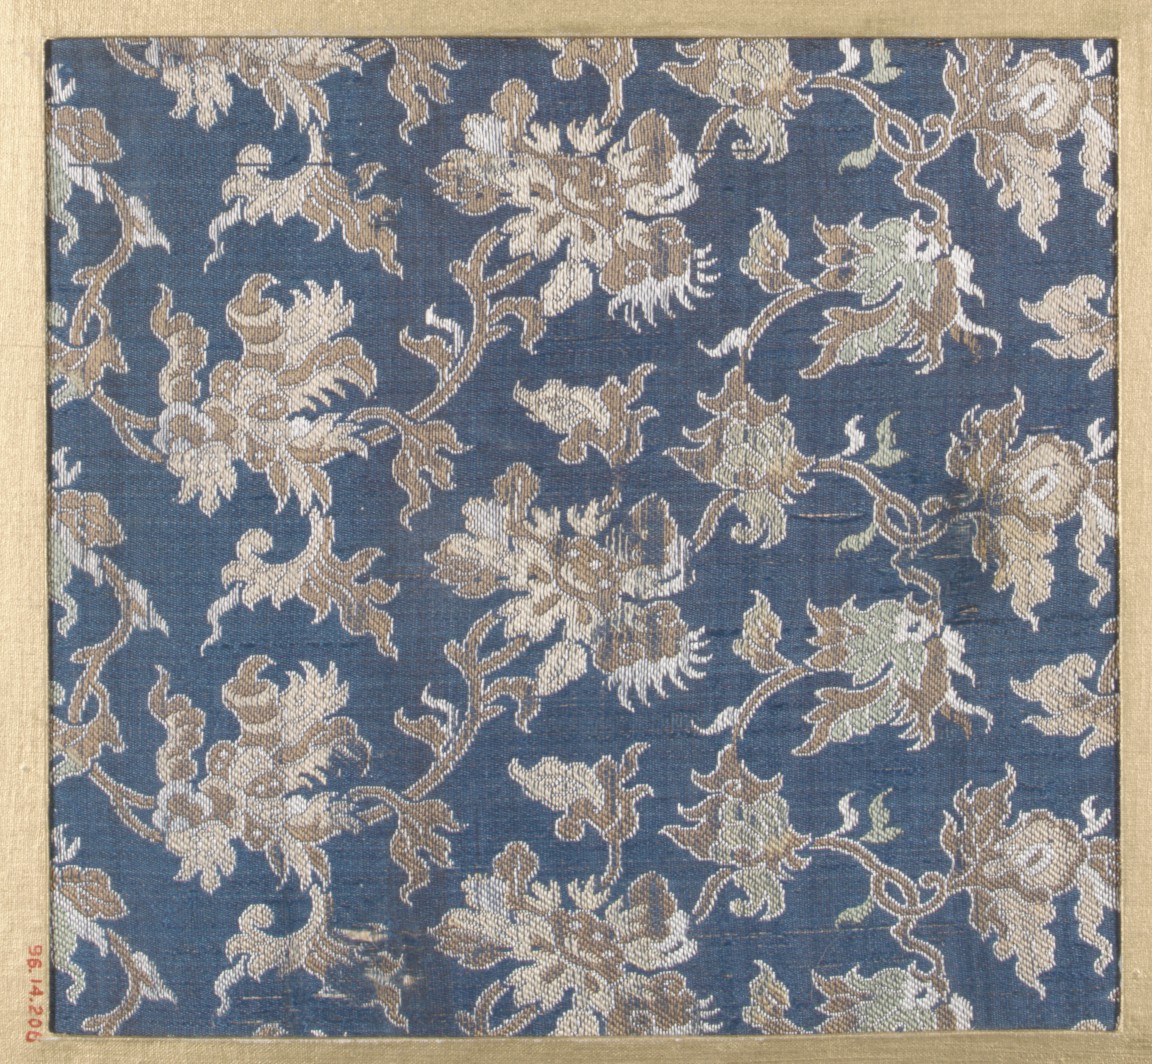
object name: piece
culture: japanese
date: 1701-1900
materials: silk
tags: flowers